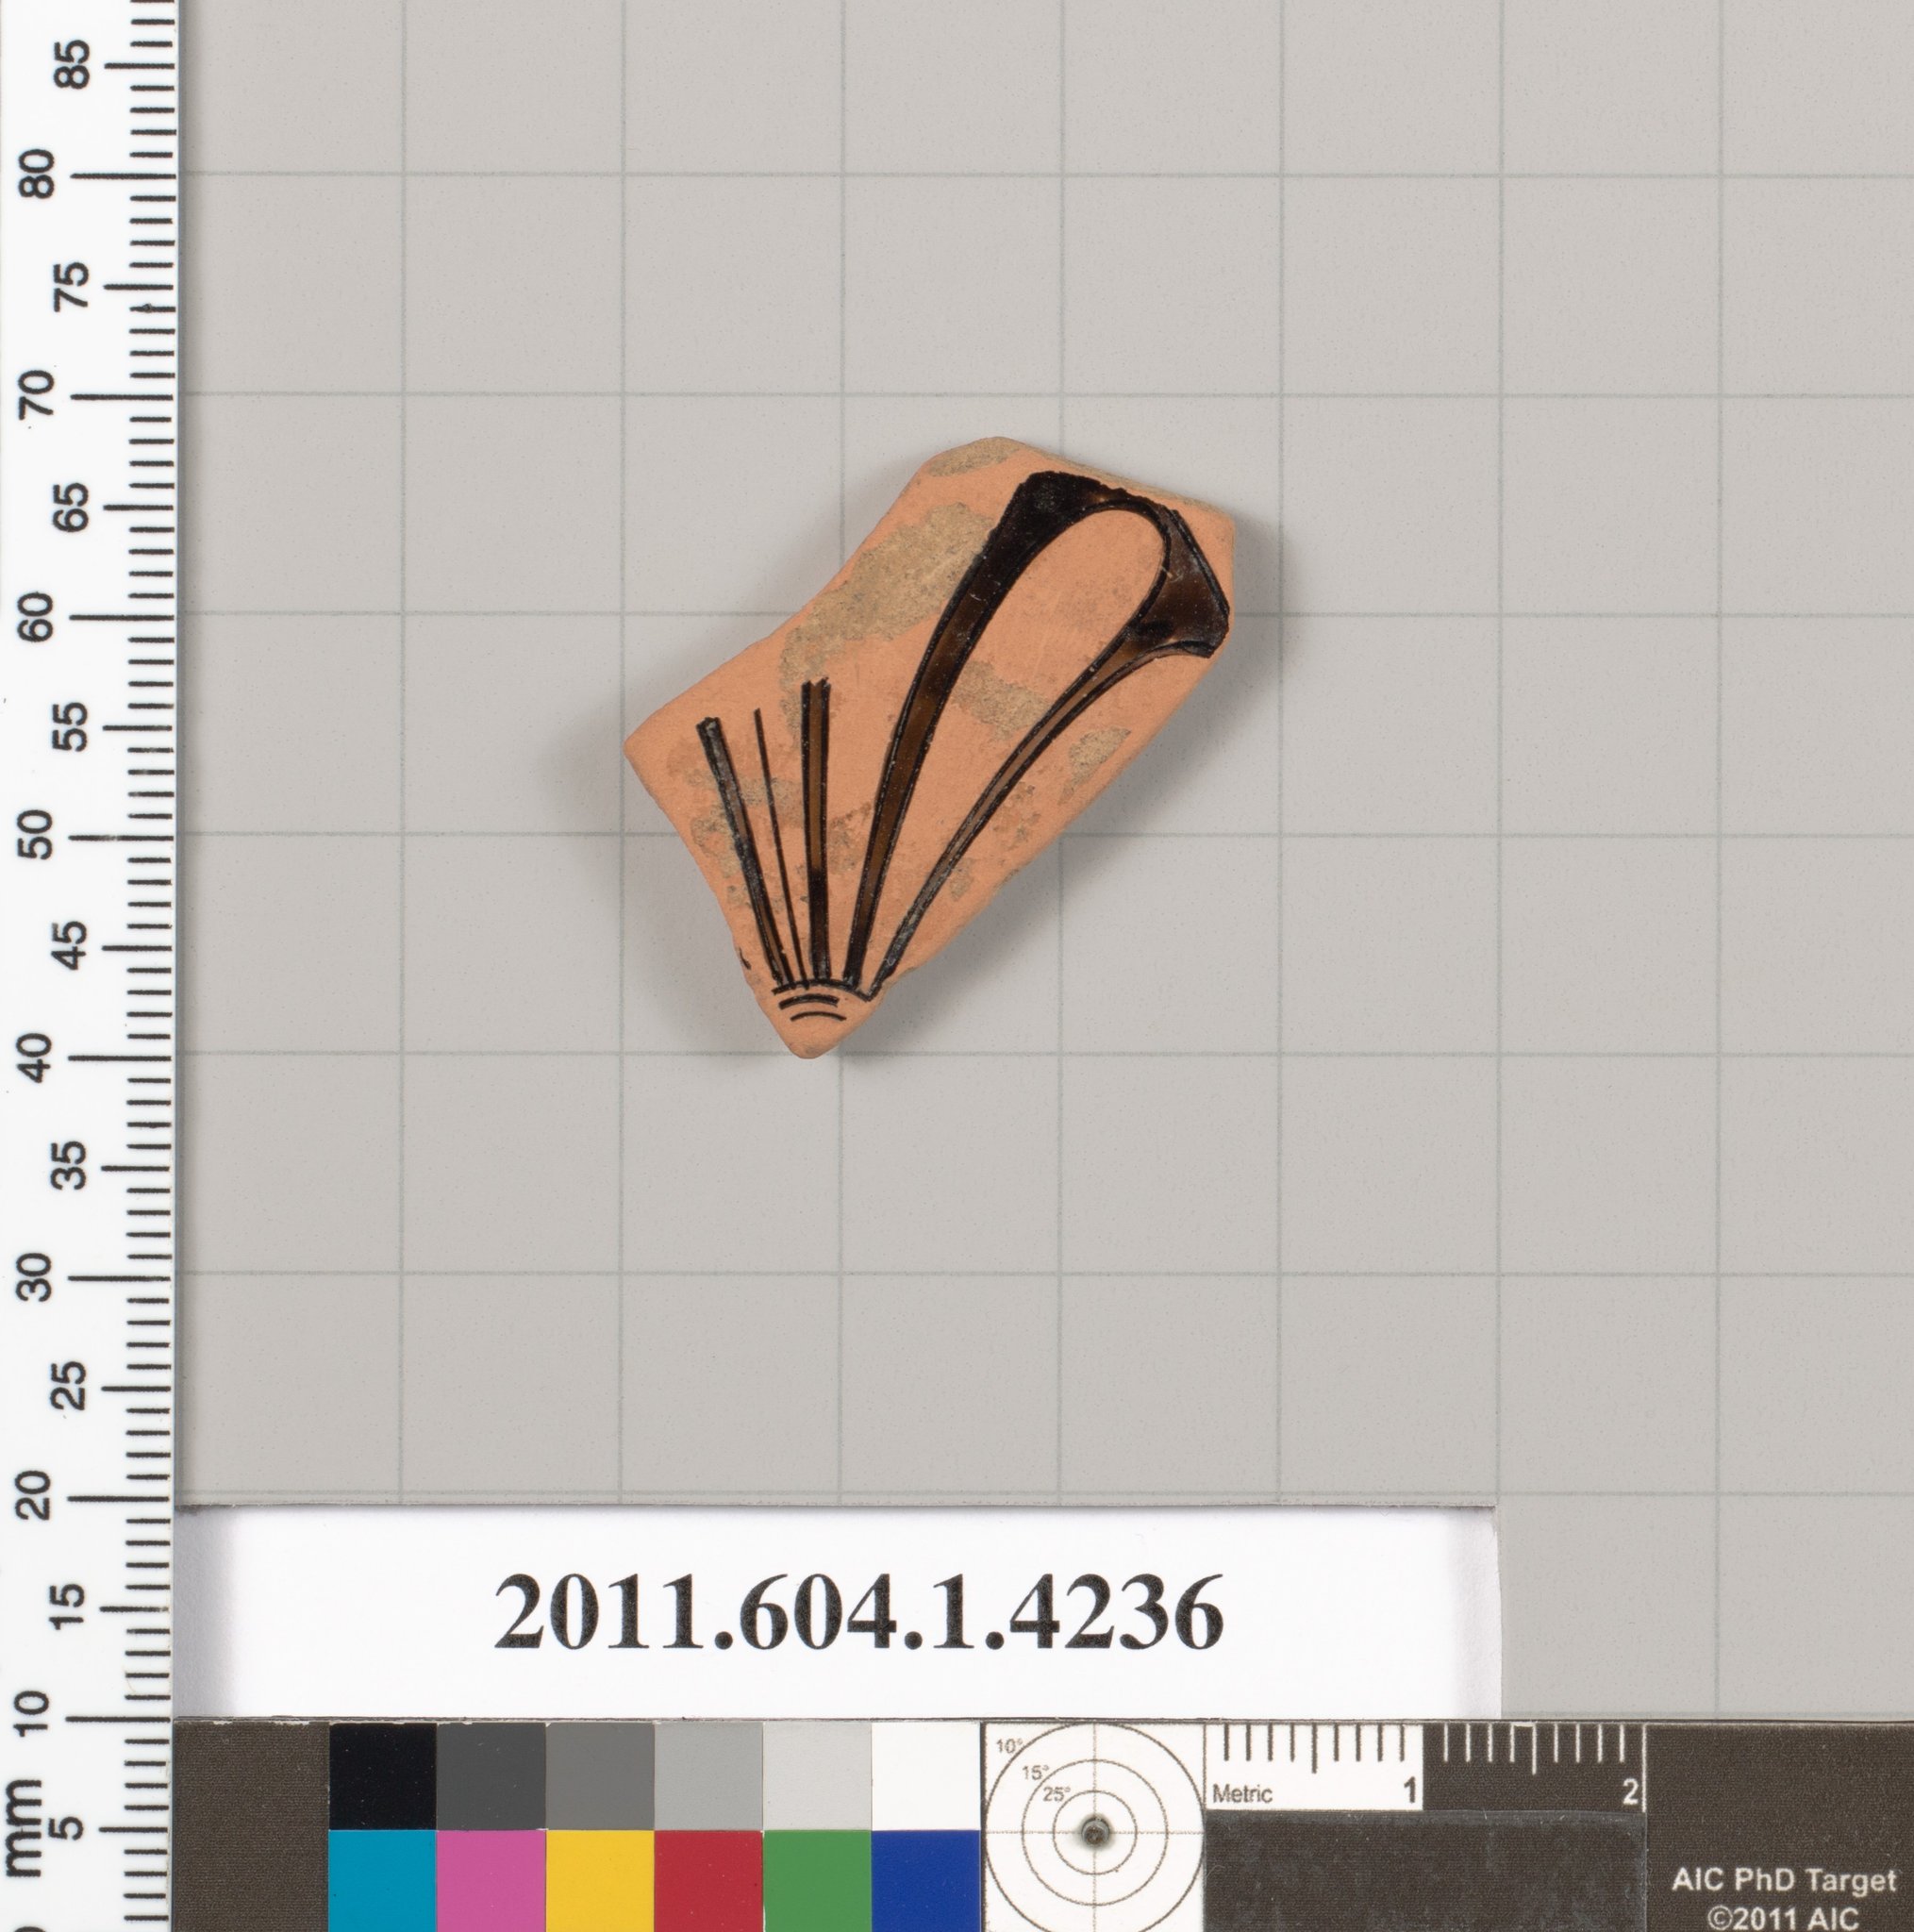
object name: kylix fragment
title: Terracotta fragment of a kylix (drinking cup)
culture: greek, attic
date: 500-476 BCE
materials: terracotta